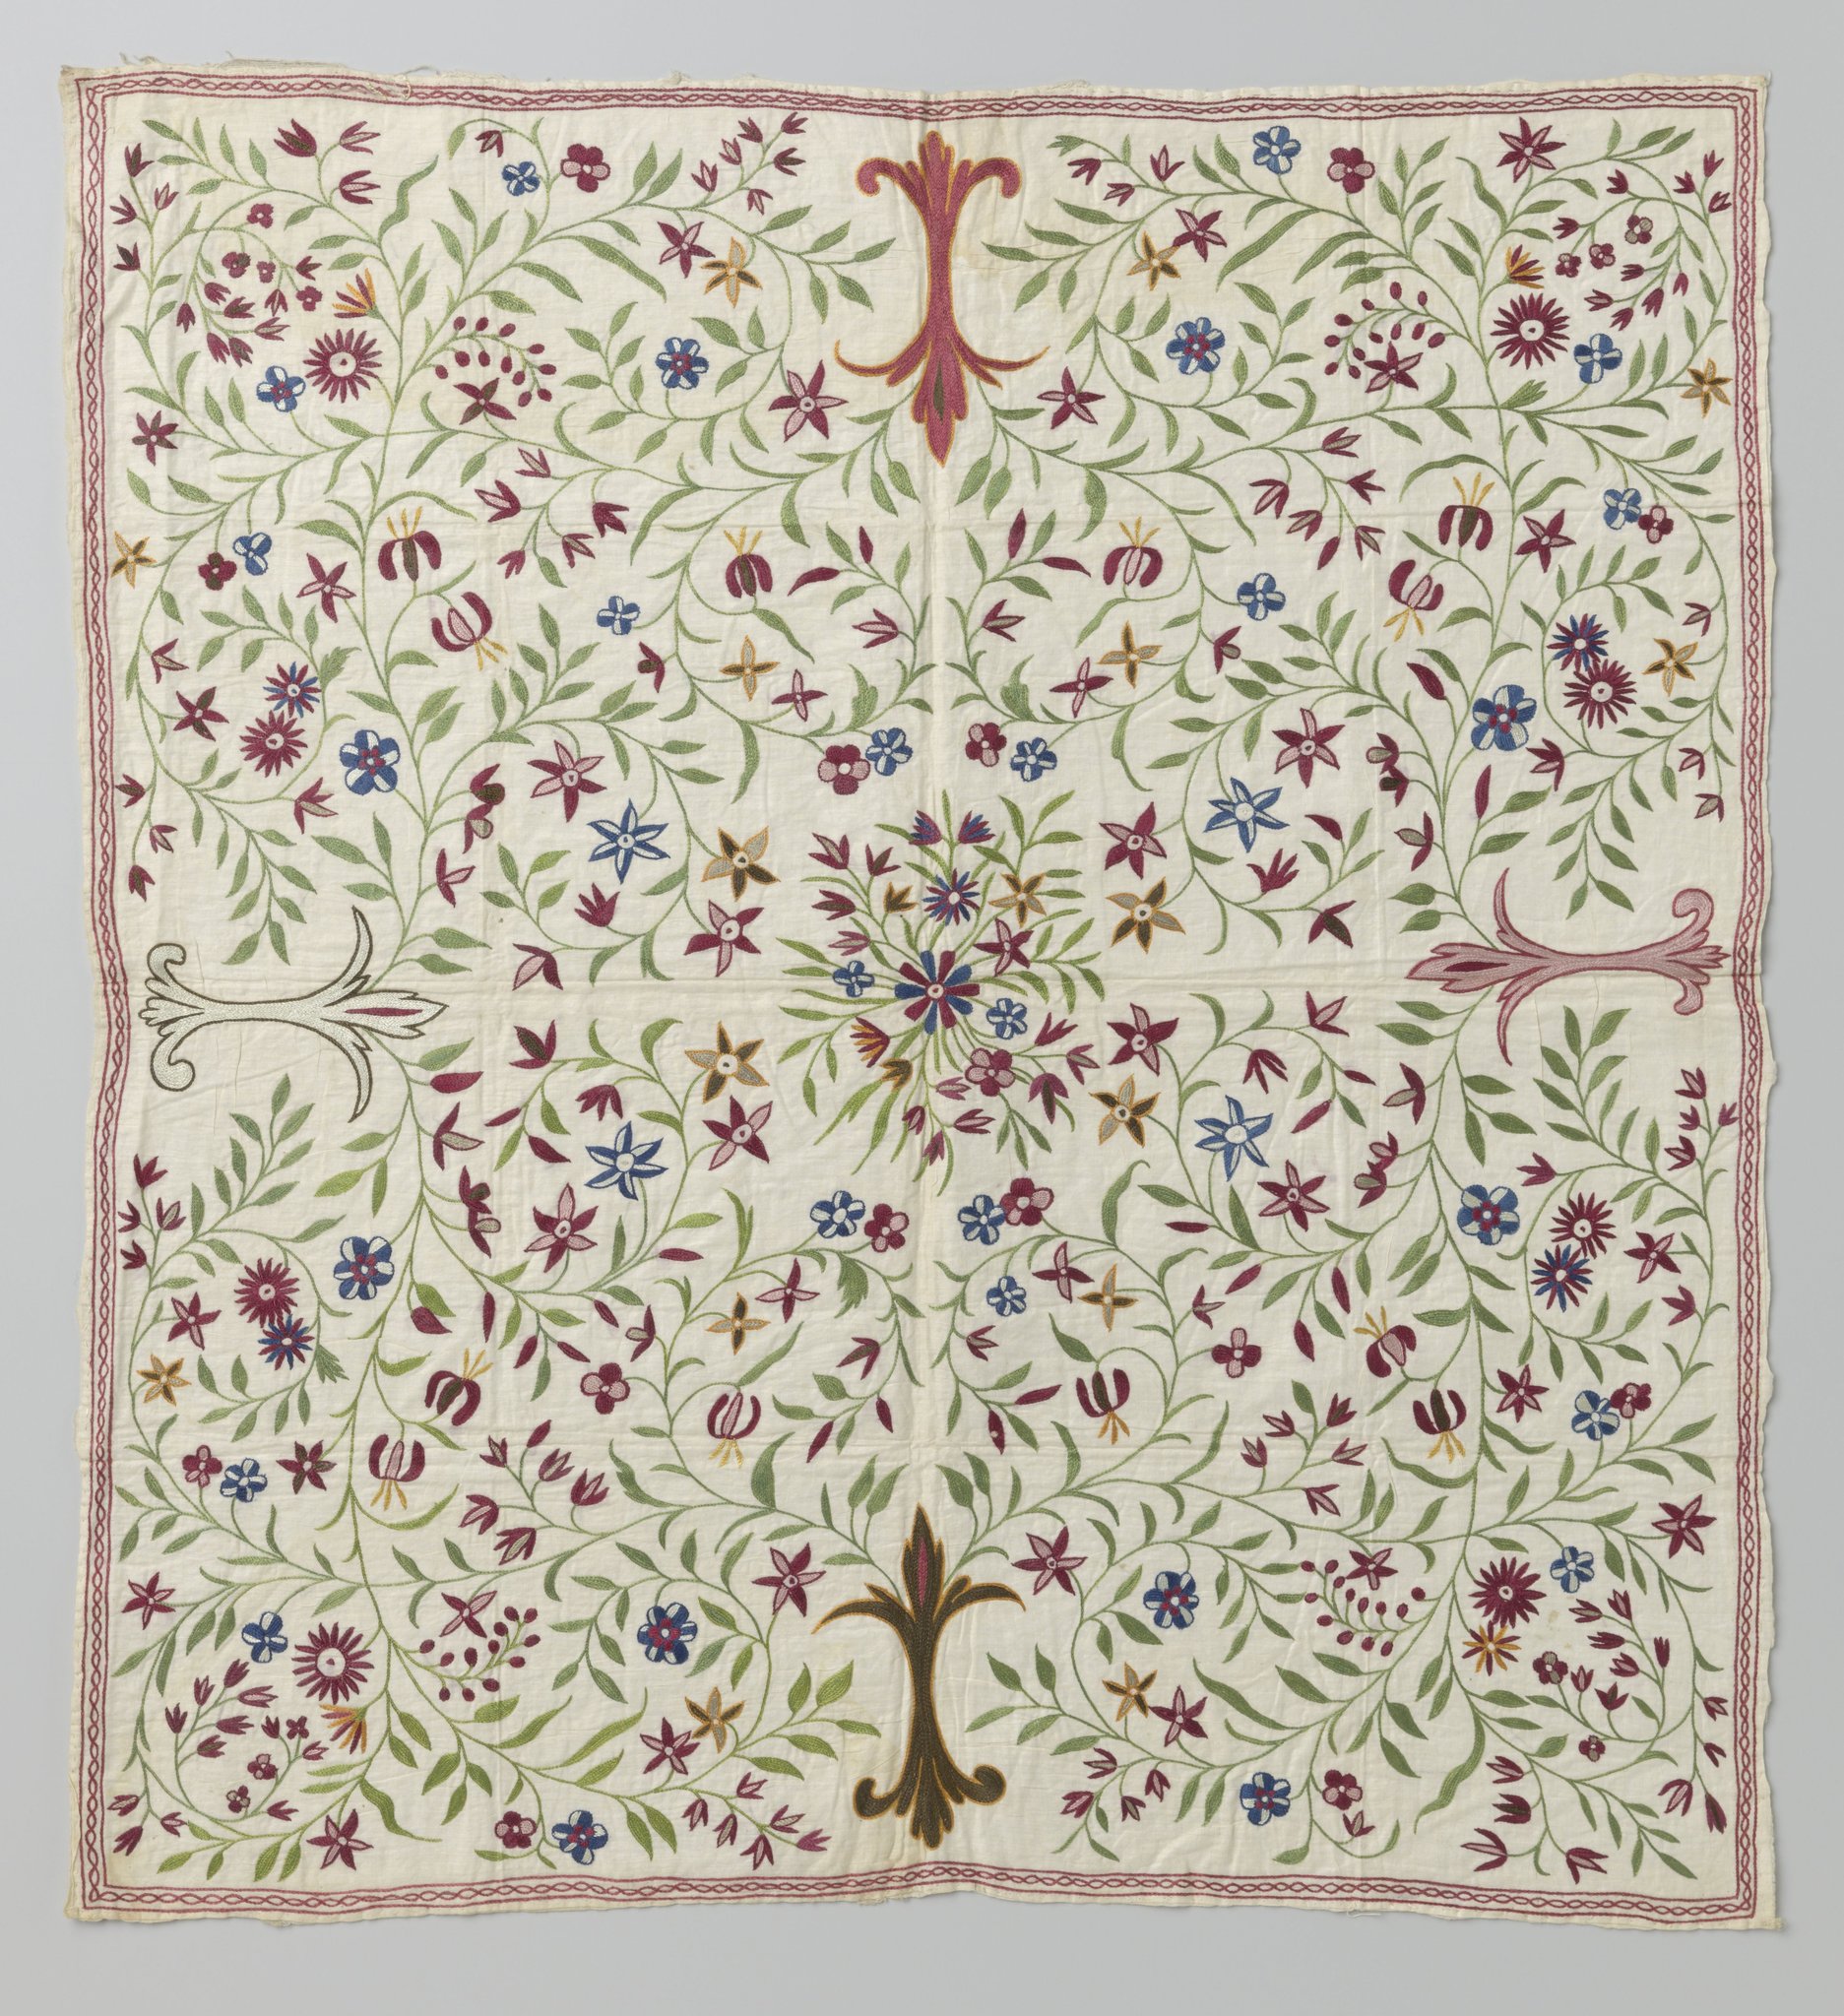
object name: kleed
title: Kleed van oosterse textiel met veelkleurig borduurwerk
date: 1800-1899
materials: cotton, silk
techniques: embroidered, weave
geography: east indies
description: Kleed van veelkleurig getamboereerde katoen, versierd met bloemenranken en ornament, gevoerd met katoen.